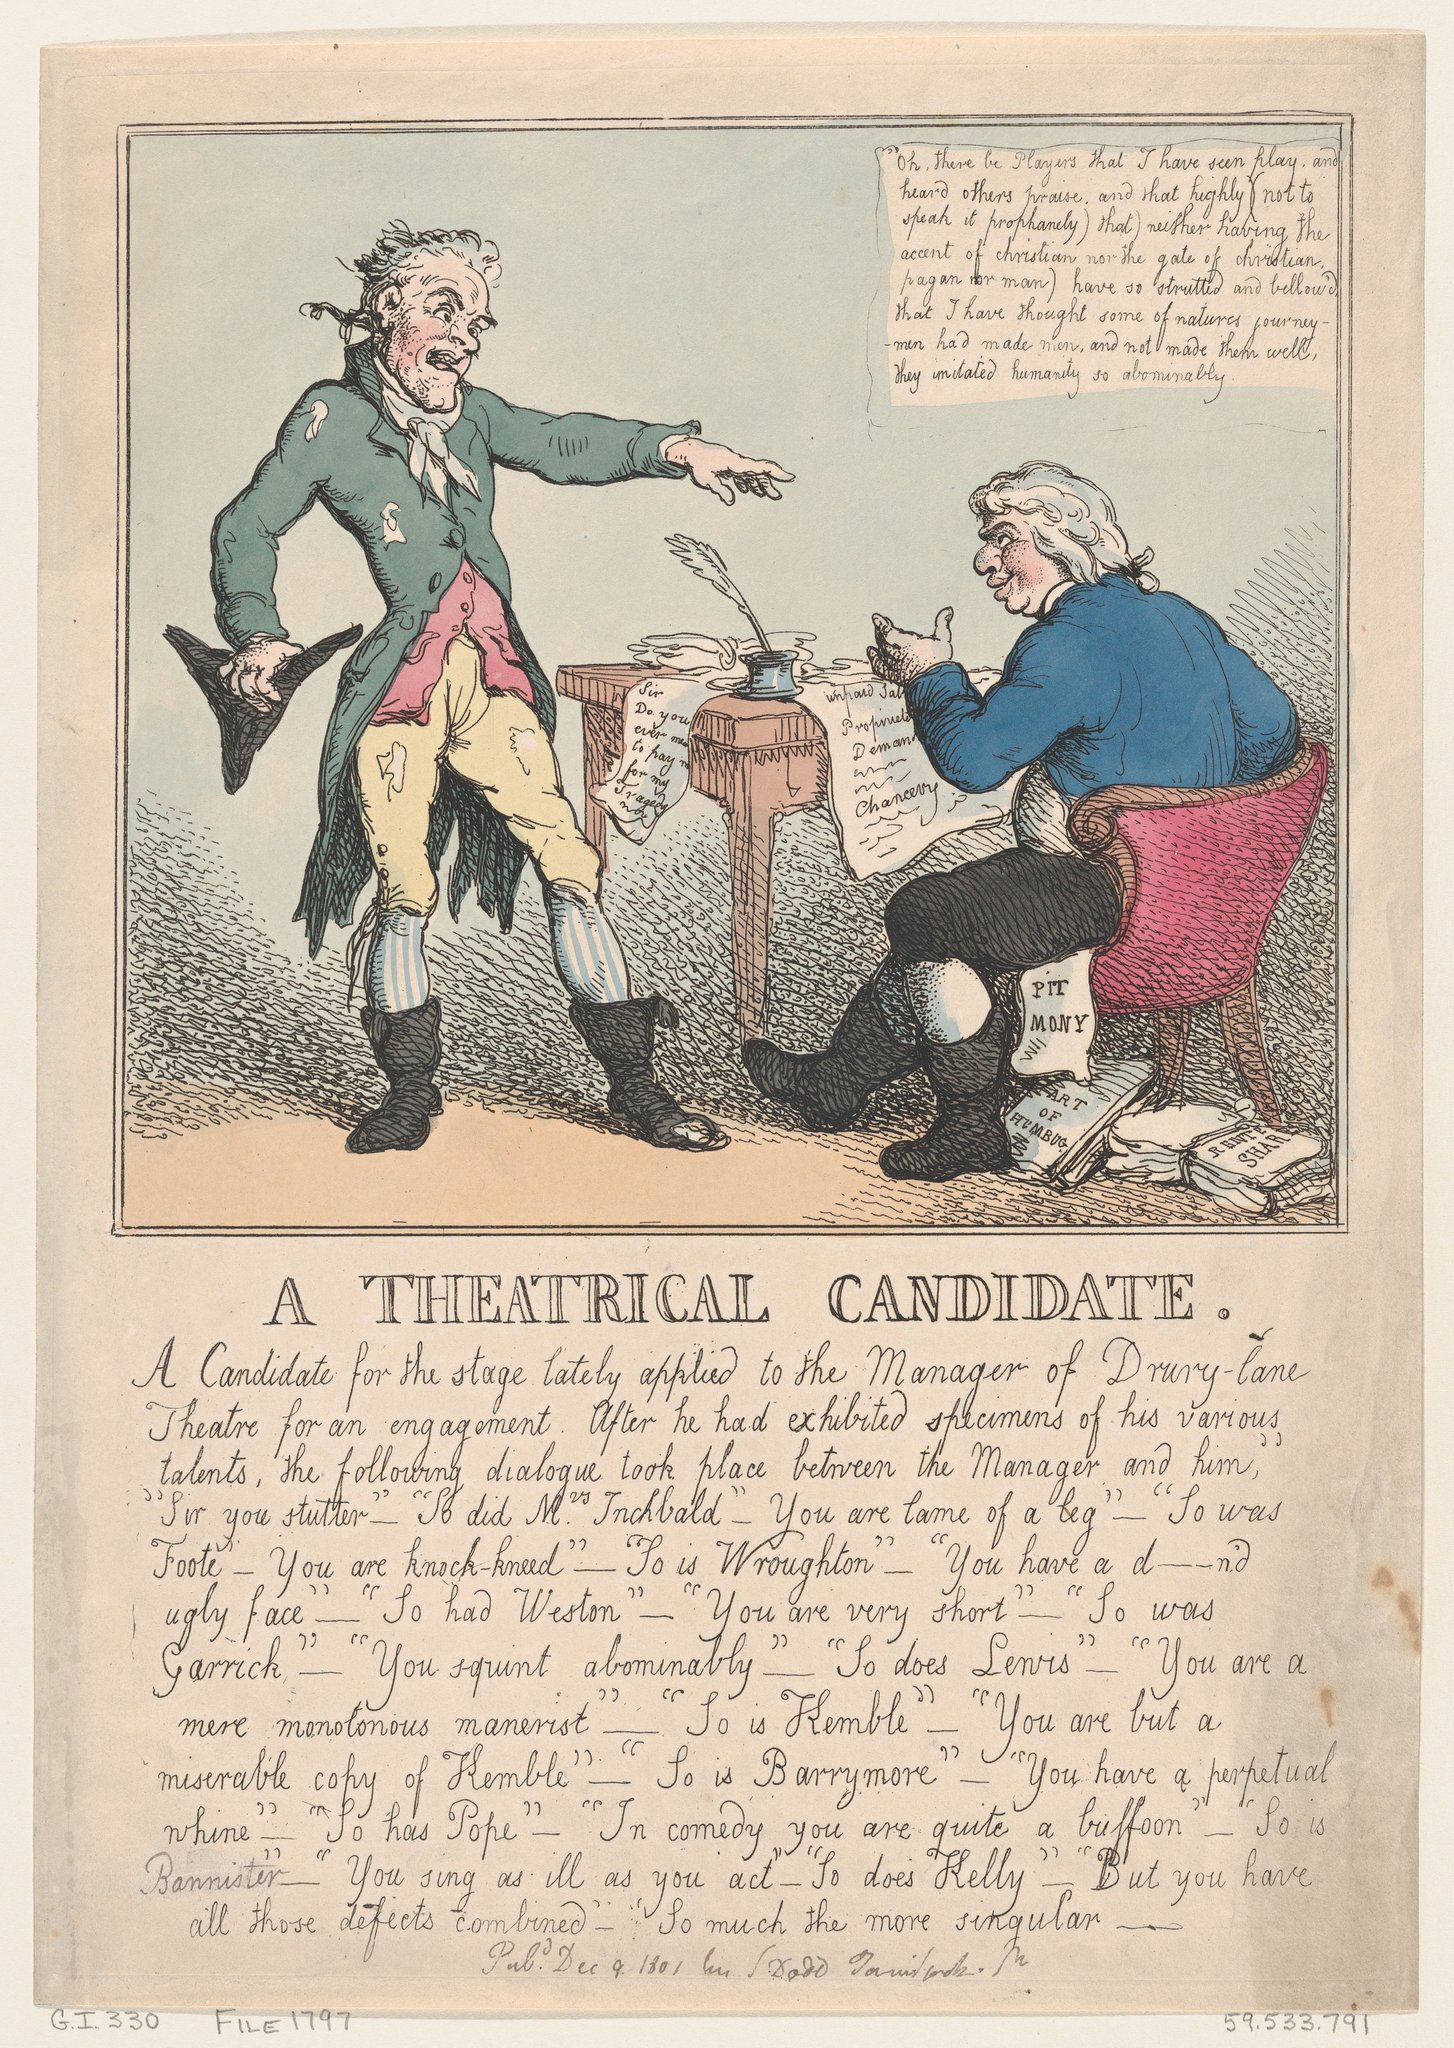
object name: print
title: A Theatrical Candidate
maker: thomas rowlandson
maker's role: artist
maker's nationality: british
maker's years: 1757-1827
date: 1797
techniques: aquatint, etching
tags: men